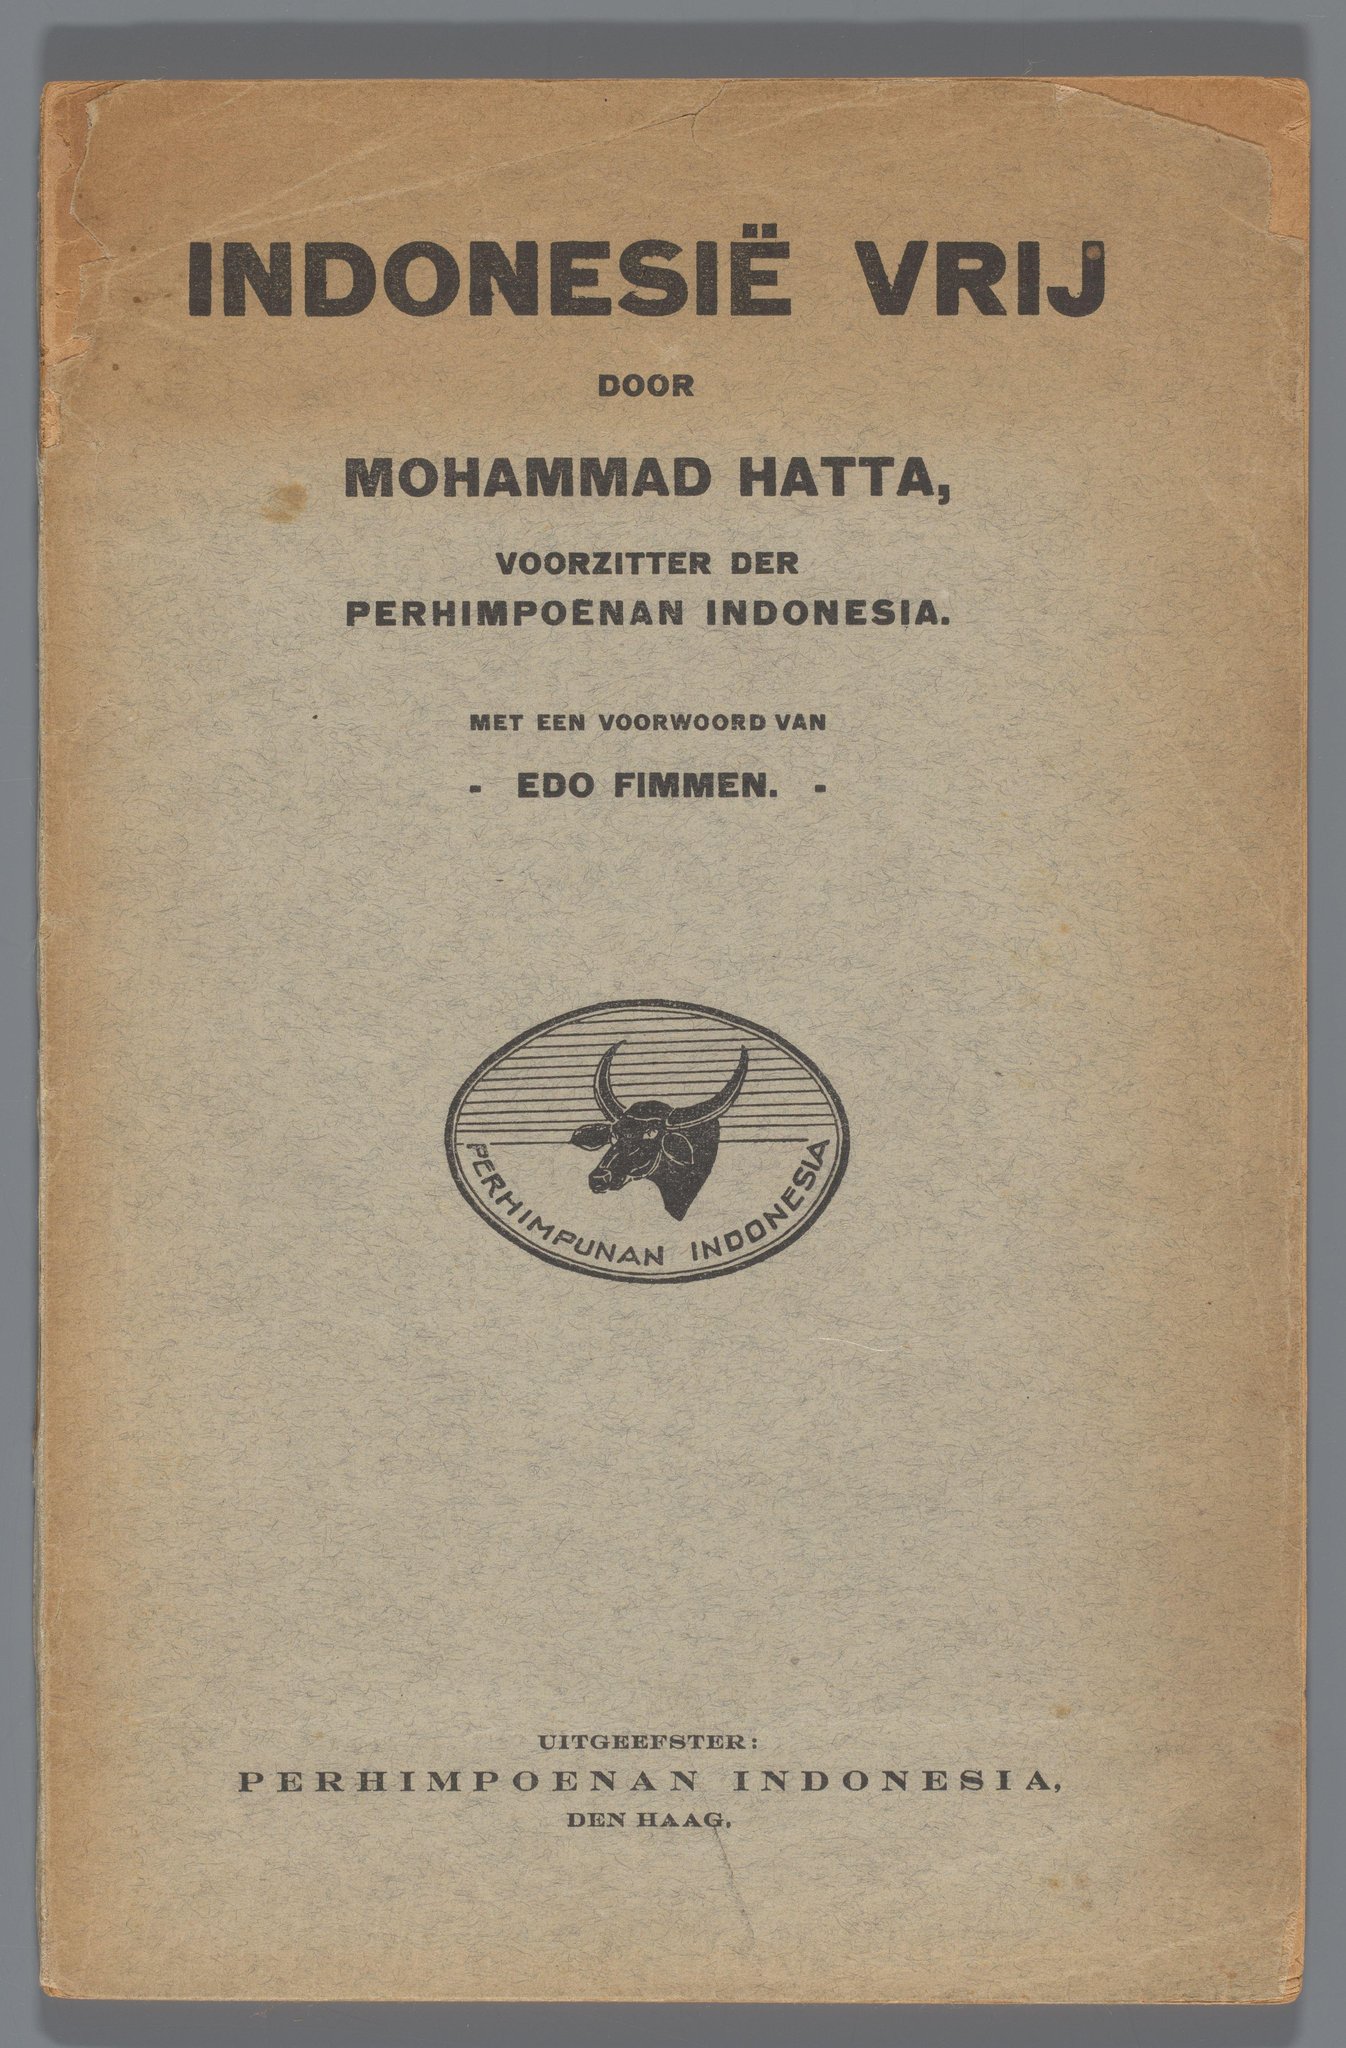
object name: brochure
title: Indonesië vrij (Indonesia Free)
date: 1928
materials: ink, paper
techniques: printing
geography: the hague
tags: mohammad hatta, netherlands, indonesia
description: The Indonesian student Mohammad Hatta was chairman of Perhimpoenan Indonesia, a nationalistic association of Indonesian students in the Netherlands. He was imprisoned in 1927 for his political activities in the Netherlands. In his defence, while in his cell he wrote Indonesië vrij (Indonesia Free) denouncing colonial abuses and championing a future in which the Indonesian people would be free of colonial oppression. The text was published shortly after he was released.